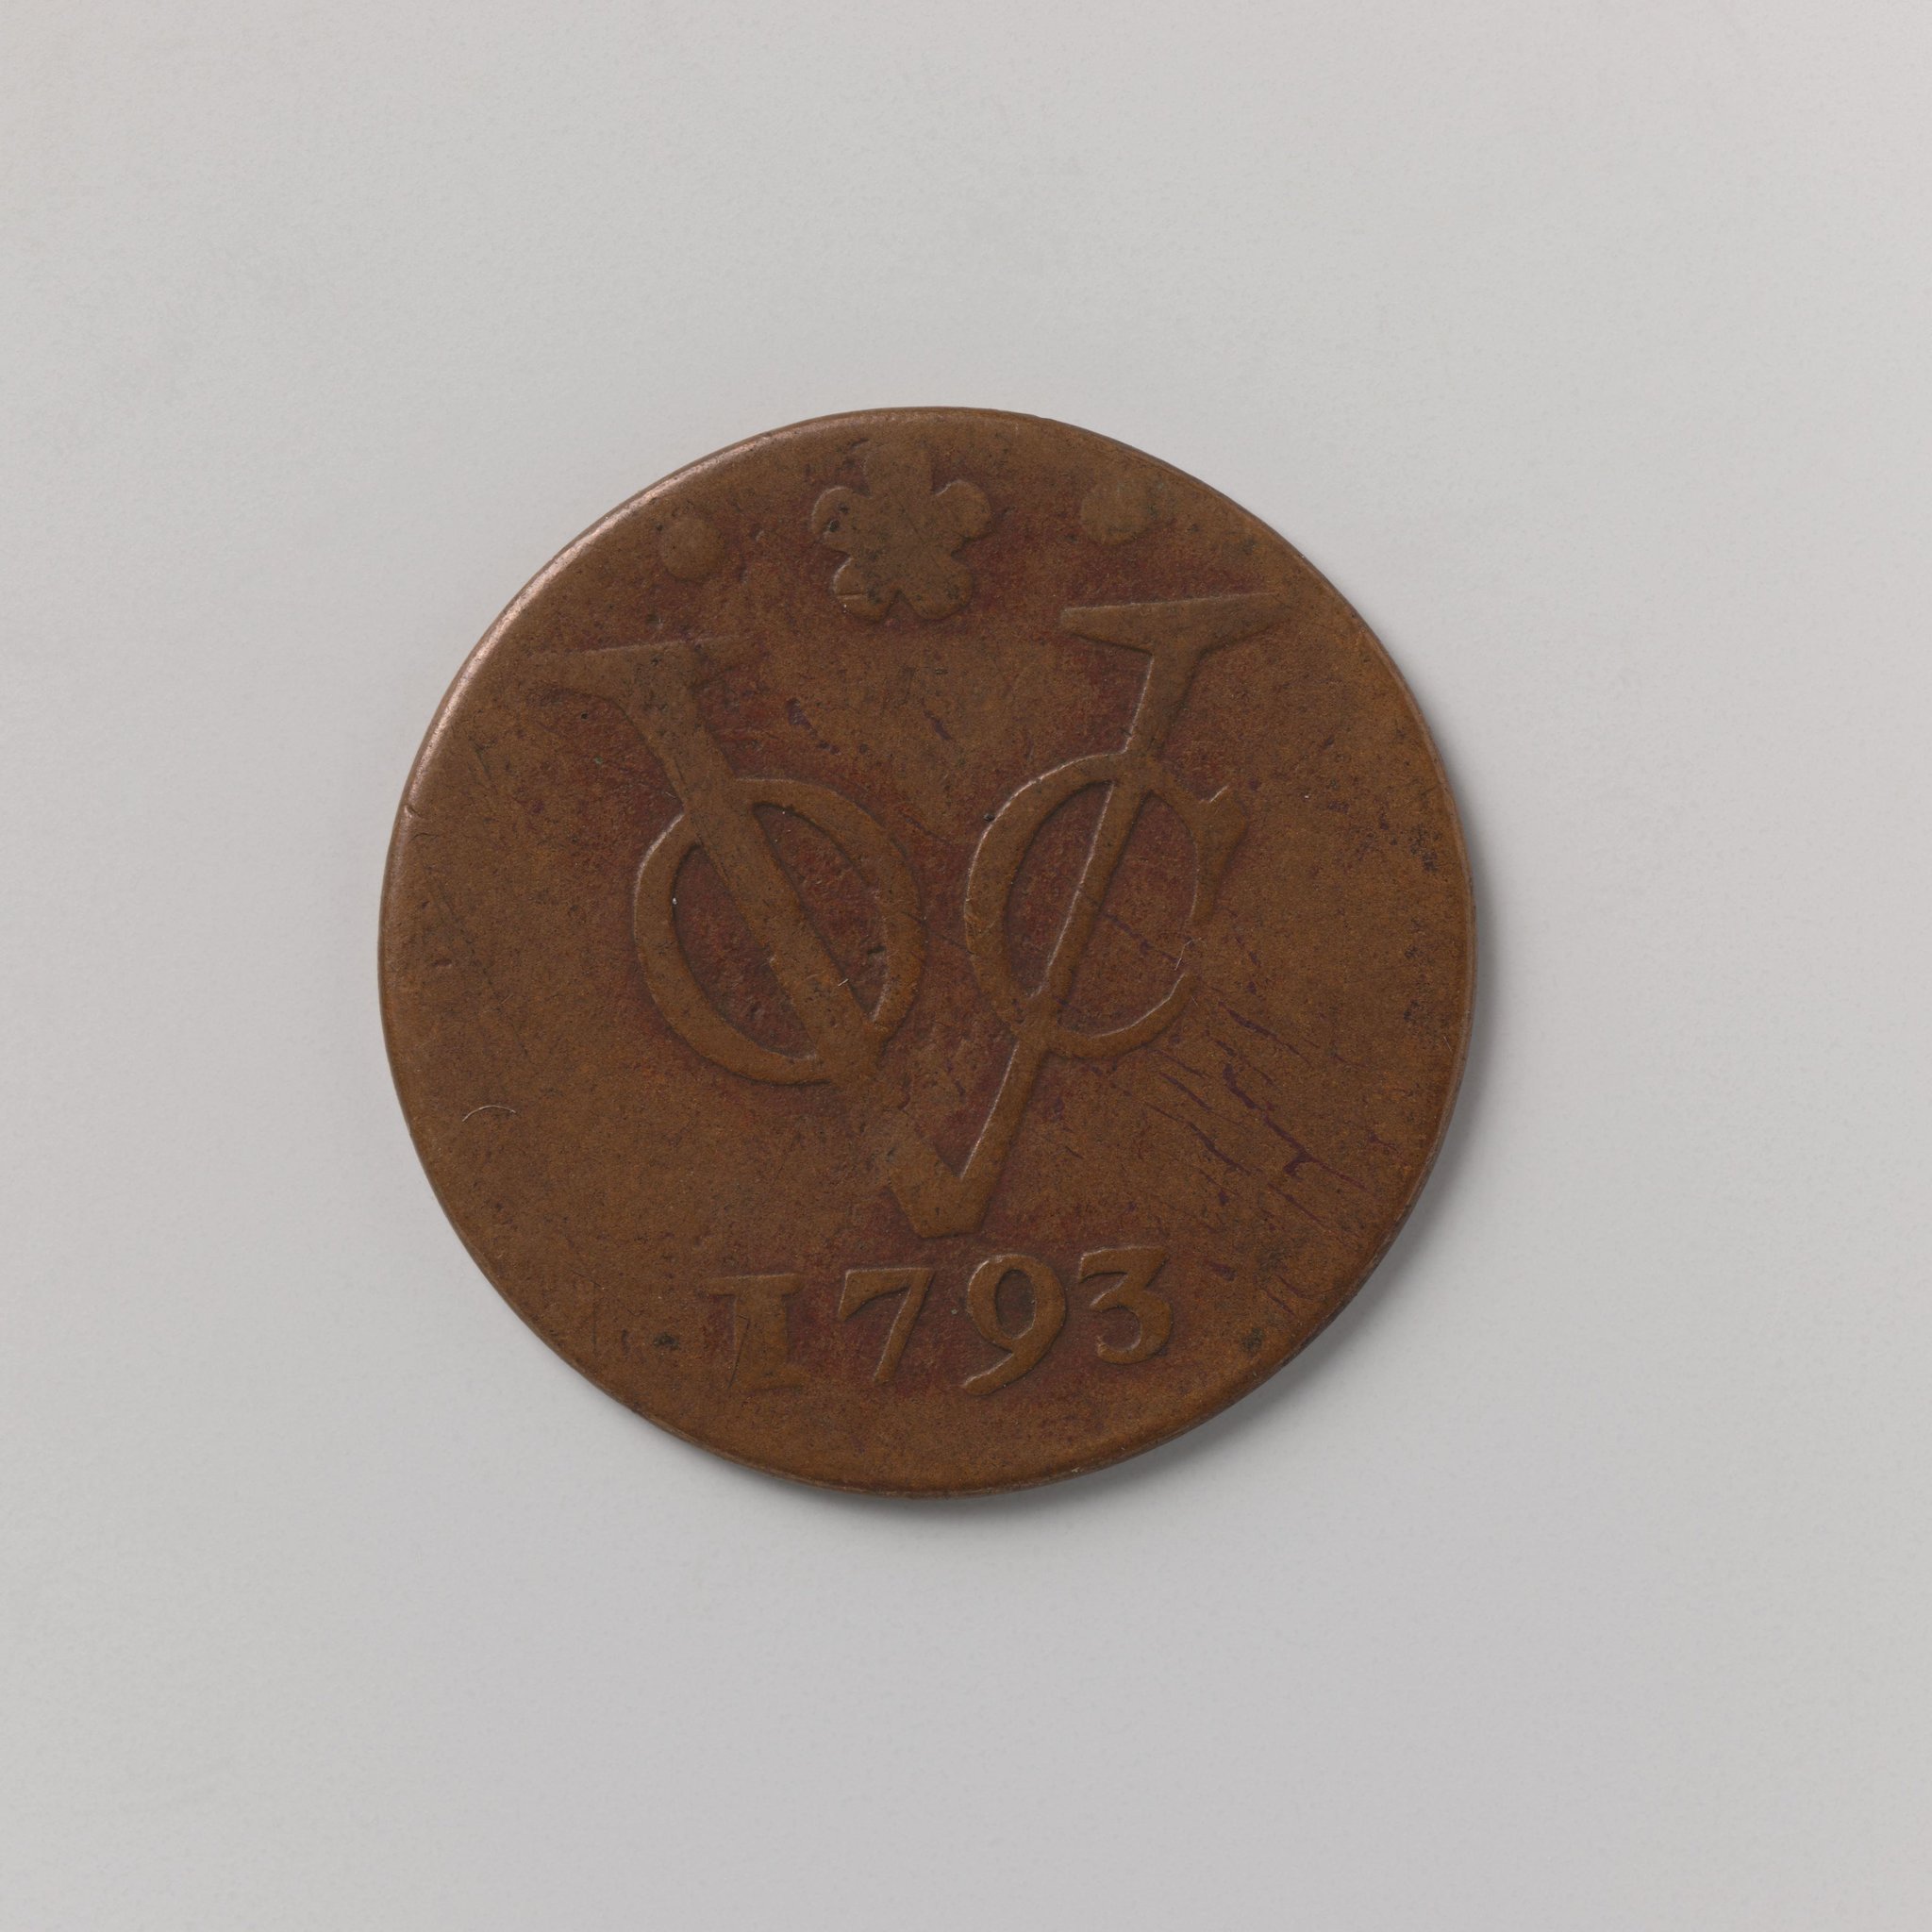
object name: coin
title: VOC, duit Holland, 1793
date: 1793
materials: copper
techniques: striking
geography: dordrecht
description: Koperen munt. Voorzijde: gekroond wapenschild van Holland. Keerzijde: monogram van de VOC, waarboven muntteken en waaronder jaartal. Gladde rand.